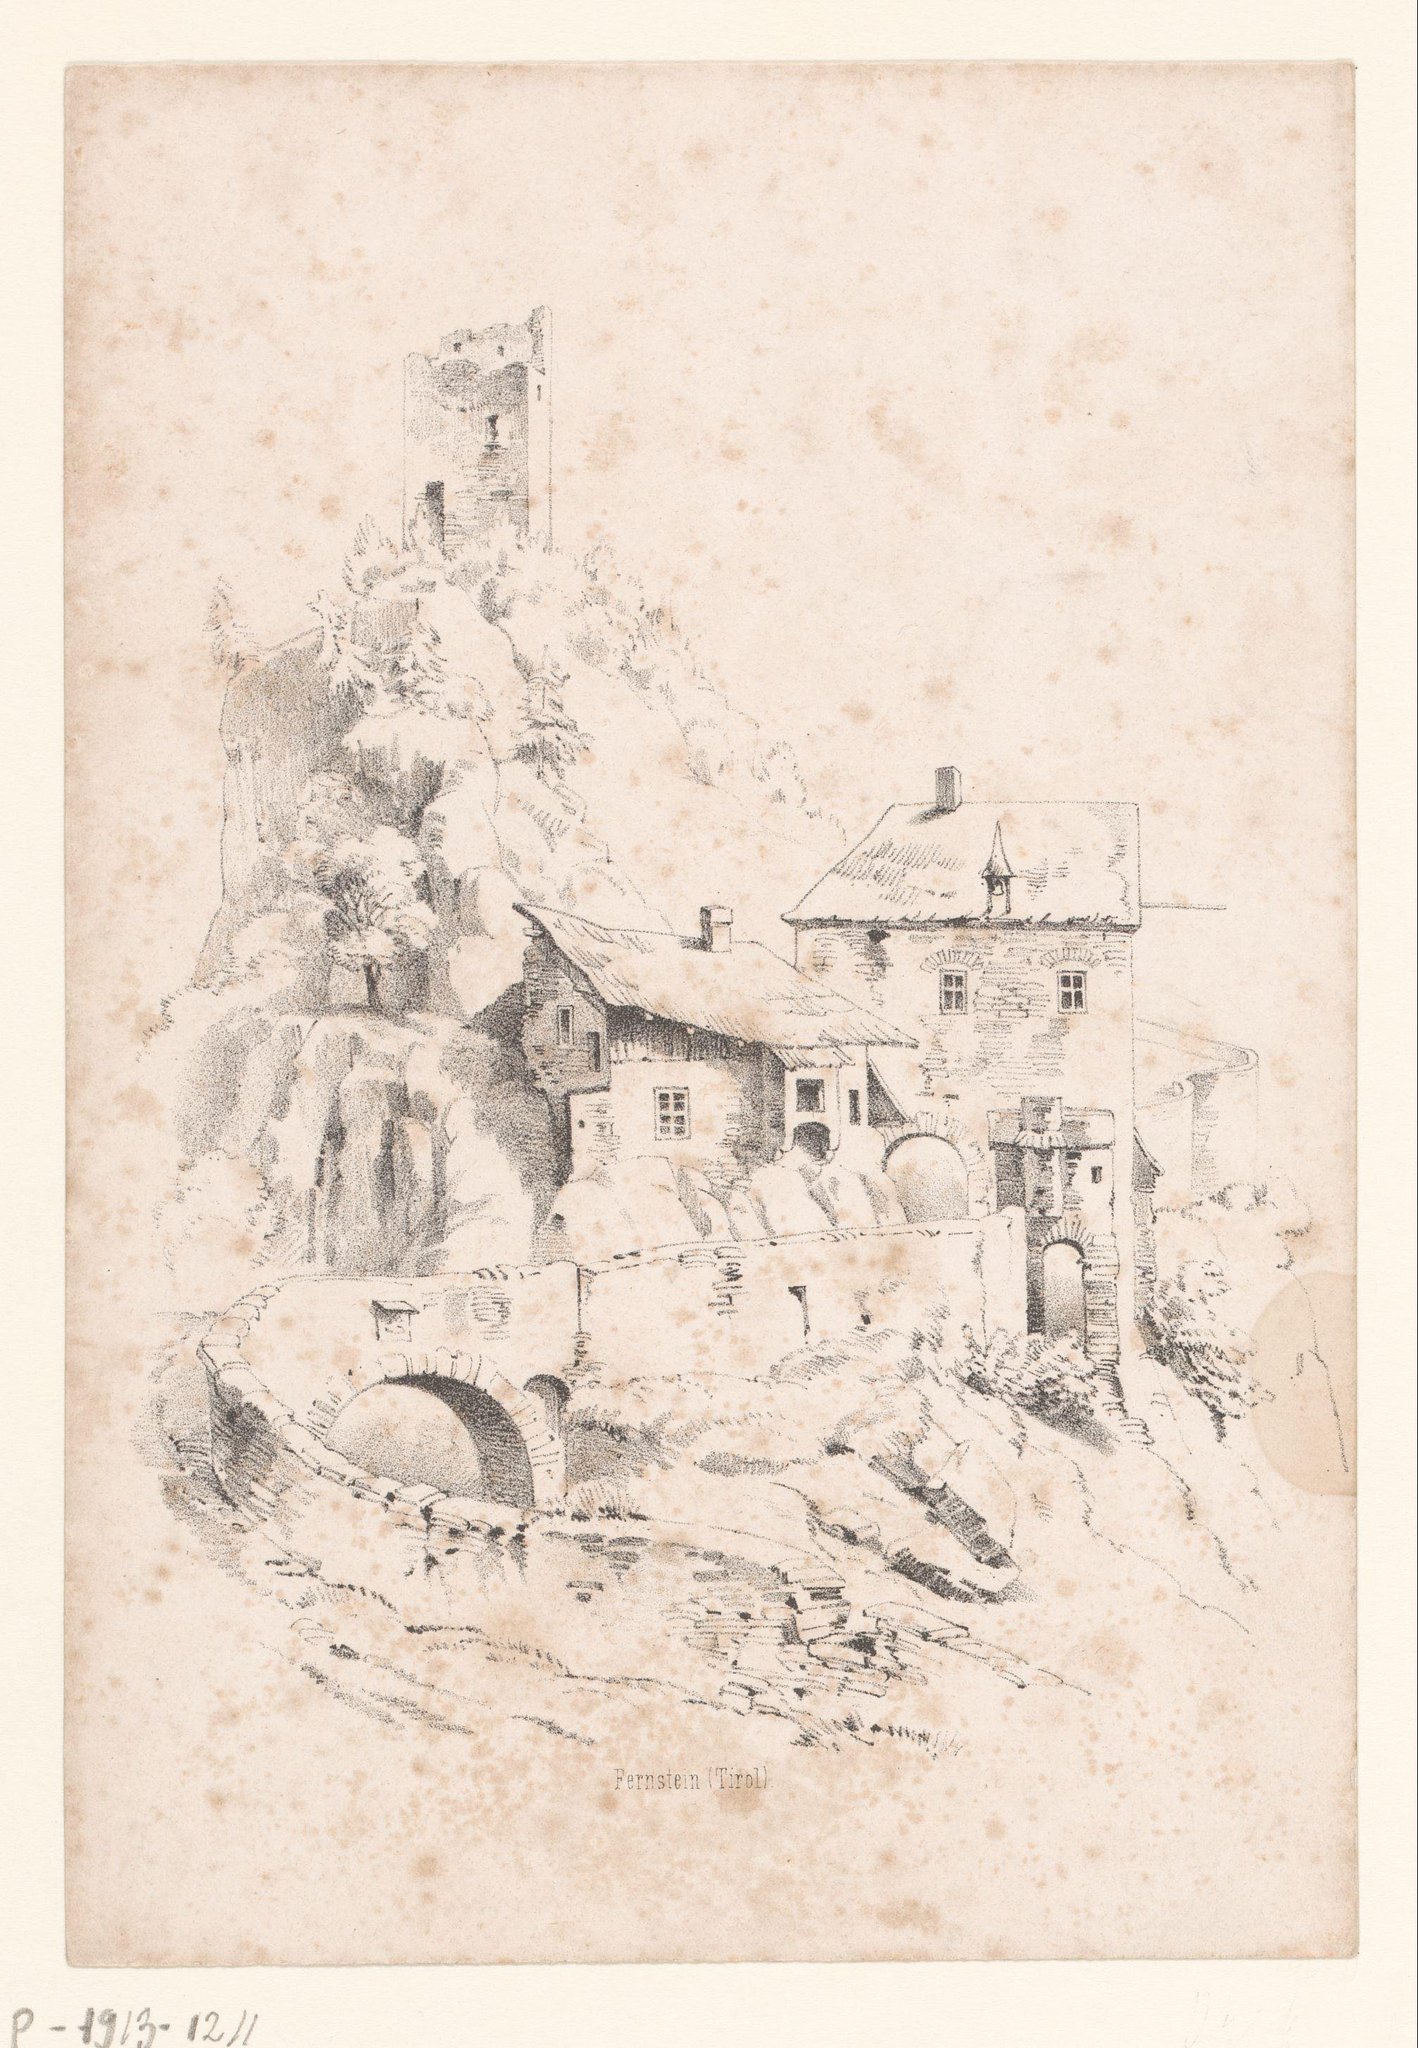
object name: print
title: Fernstein (Tirol)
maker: Anonymous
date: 1800-1899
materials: paper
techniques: lithograph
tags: castle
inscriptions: collector's mark: Lugt 2228